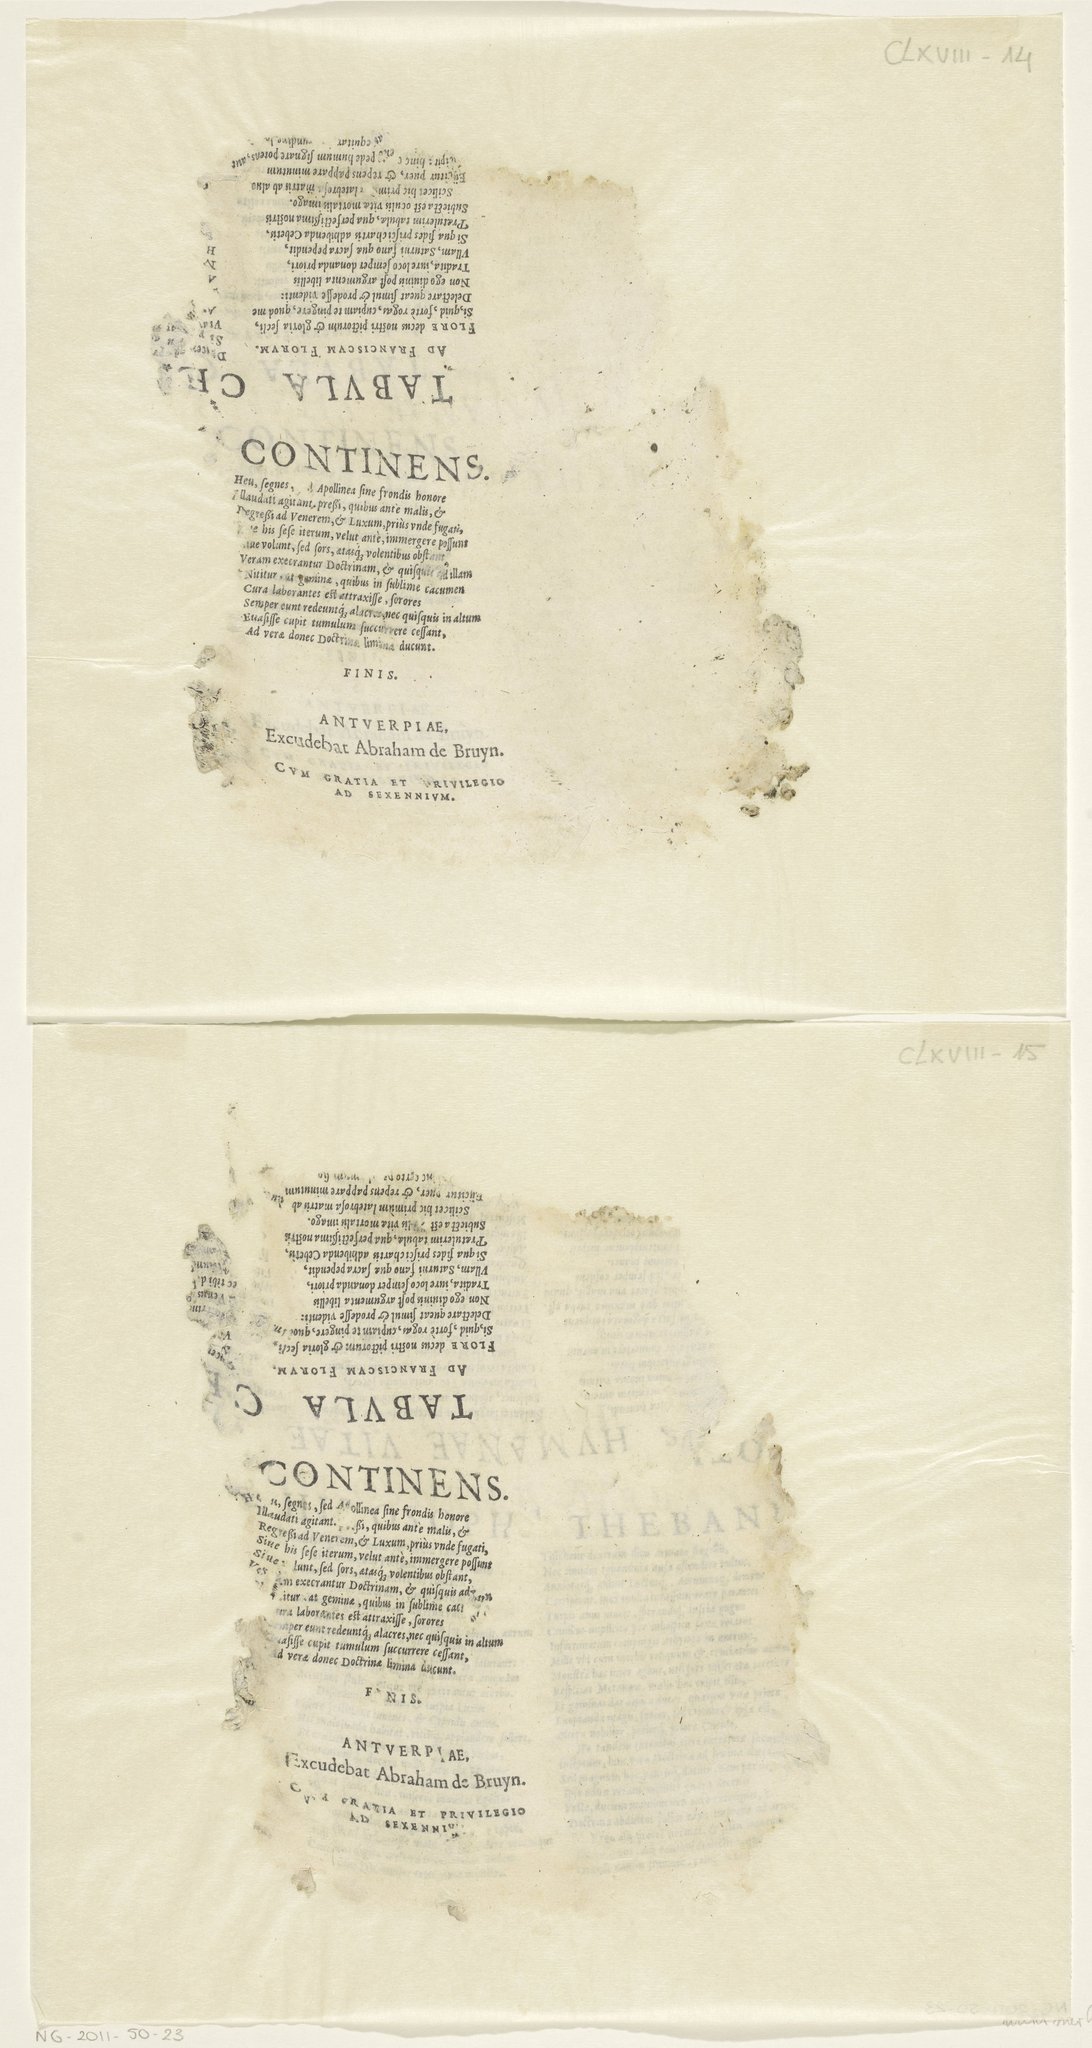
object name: text sheet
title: Twee fragmenten van tekst bij een prent van het tafereel van Cebes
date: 1561-1596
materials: paper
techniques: letterpress printing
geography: antwerp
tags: 'tabula cebetis'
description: Het tekstblad bestond origineel uit twee bladen. De prenten in de Nova Zembla collectie zijn tijdens een expeditie van Willem Barendsz en Jacob van Heemskerk in 1596-1597 noodgedwongen in het winterkamp, het ‘Behouden Huis’, op het eiland achtergelaten. De prenten waren in één of meerdere stapels als handelswaar meegenomen vanuit Amsterdam. Bijna drie eeuwen later, in 1871, keerde de Noor Elling Carlsen terug naar Nova Zembla en vond daar de restanten van het ‘Behouden Huis, inclusief een groot deel van de inventaris. Een deel van de prenten, in de vorm van aaneengekoekte kluiten, werd toen ook teruggevonden. De papierkluiten waren soms op meerdere plekken gebroken. Tussen 1975-1979 zijn de prenten van elkaar gescheiden. Dit leverde in totaal ca. 1000 fragmenten van ca. 400 afdrukken van ca. 150 verschillende prenten op. Voor zover mogelijk zijn de fragmenten samengevoegd en zijn de prenten gereconstrueerd.